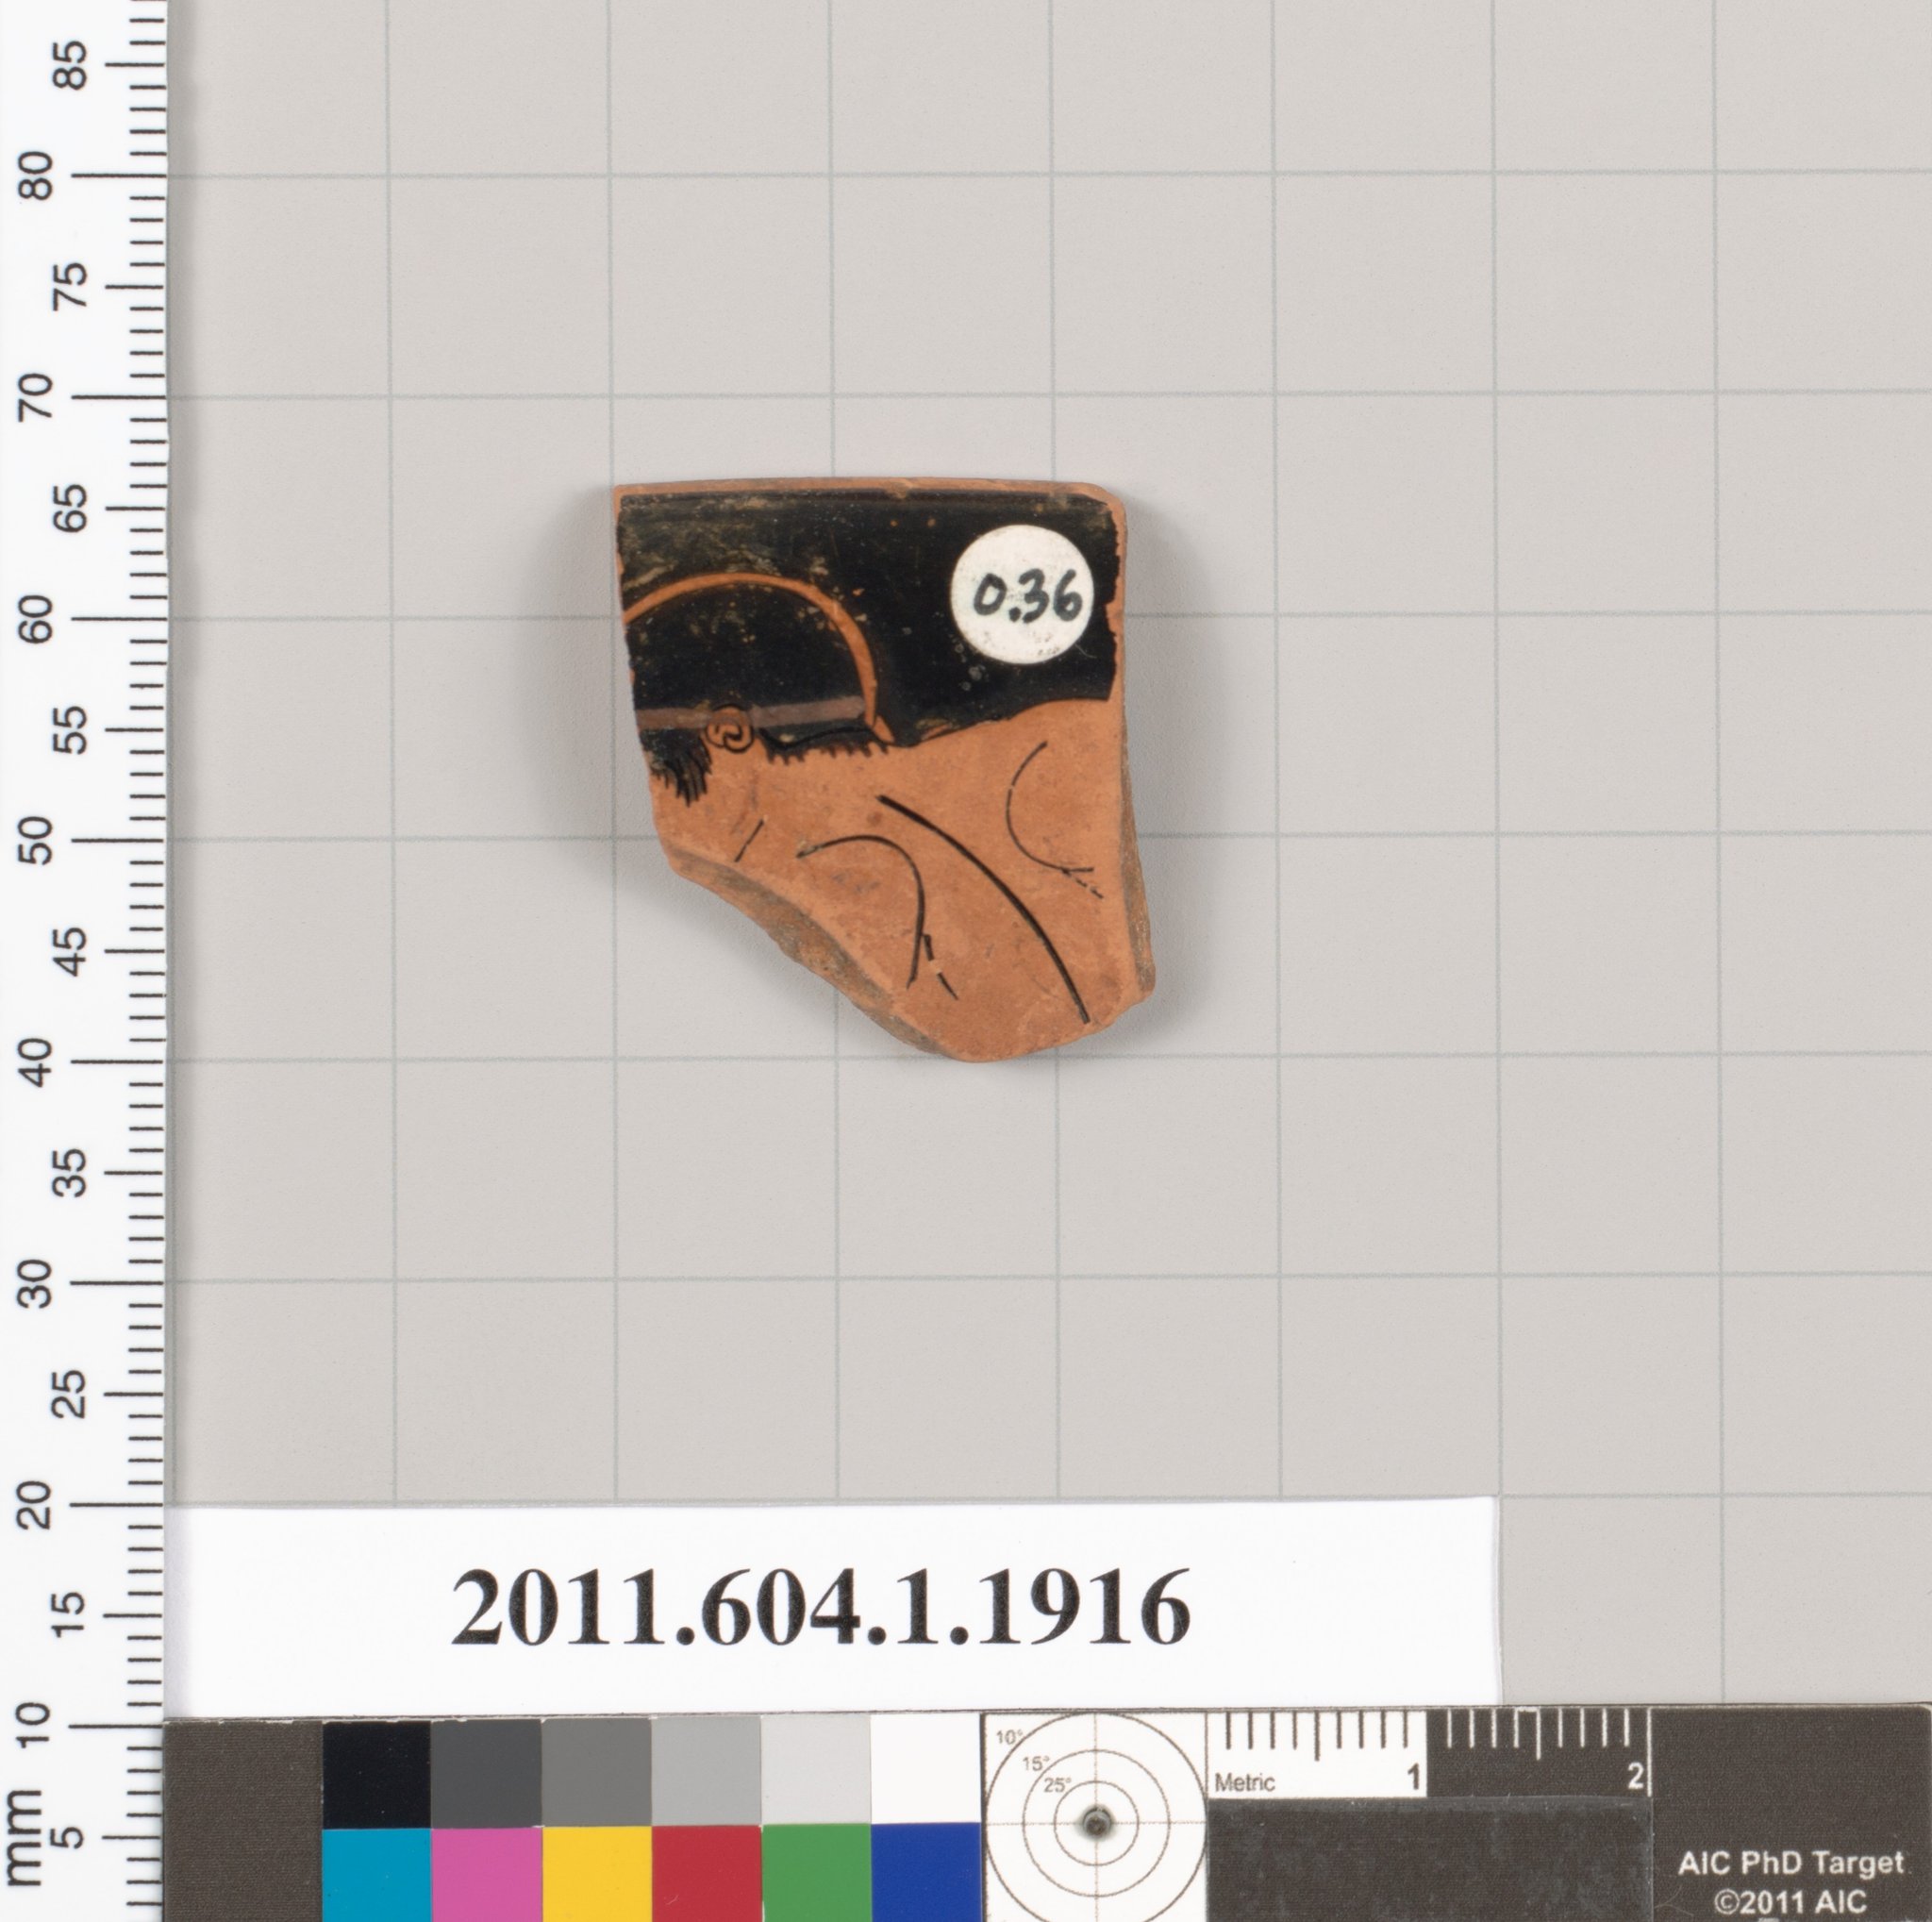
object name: kylix fragment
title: Terracotta rim fragment of a kylix (drinking cup)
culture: greek, attic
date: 490-480 BCE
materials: terracotta